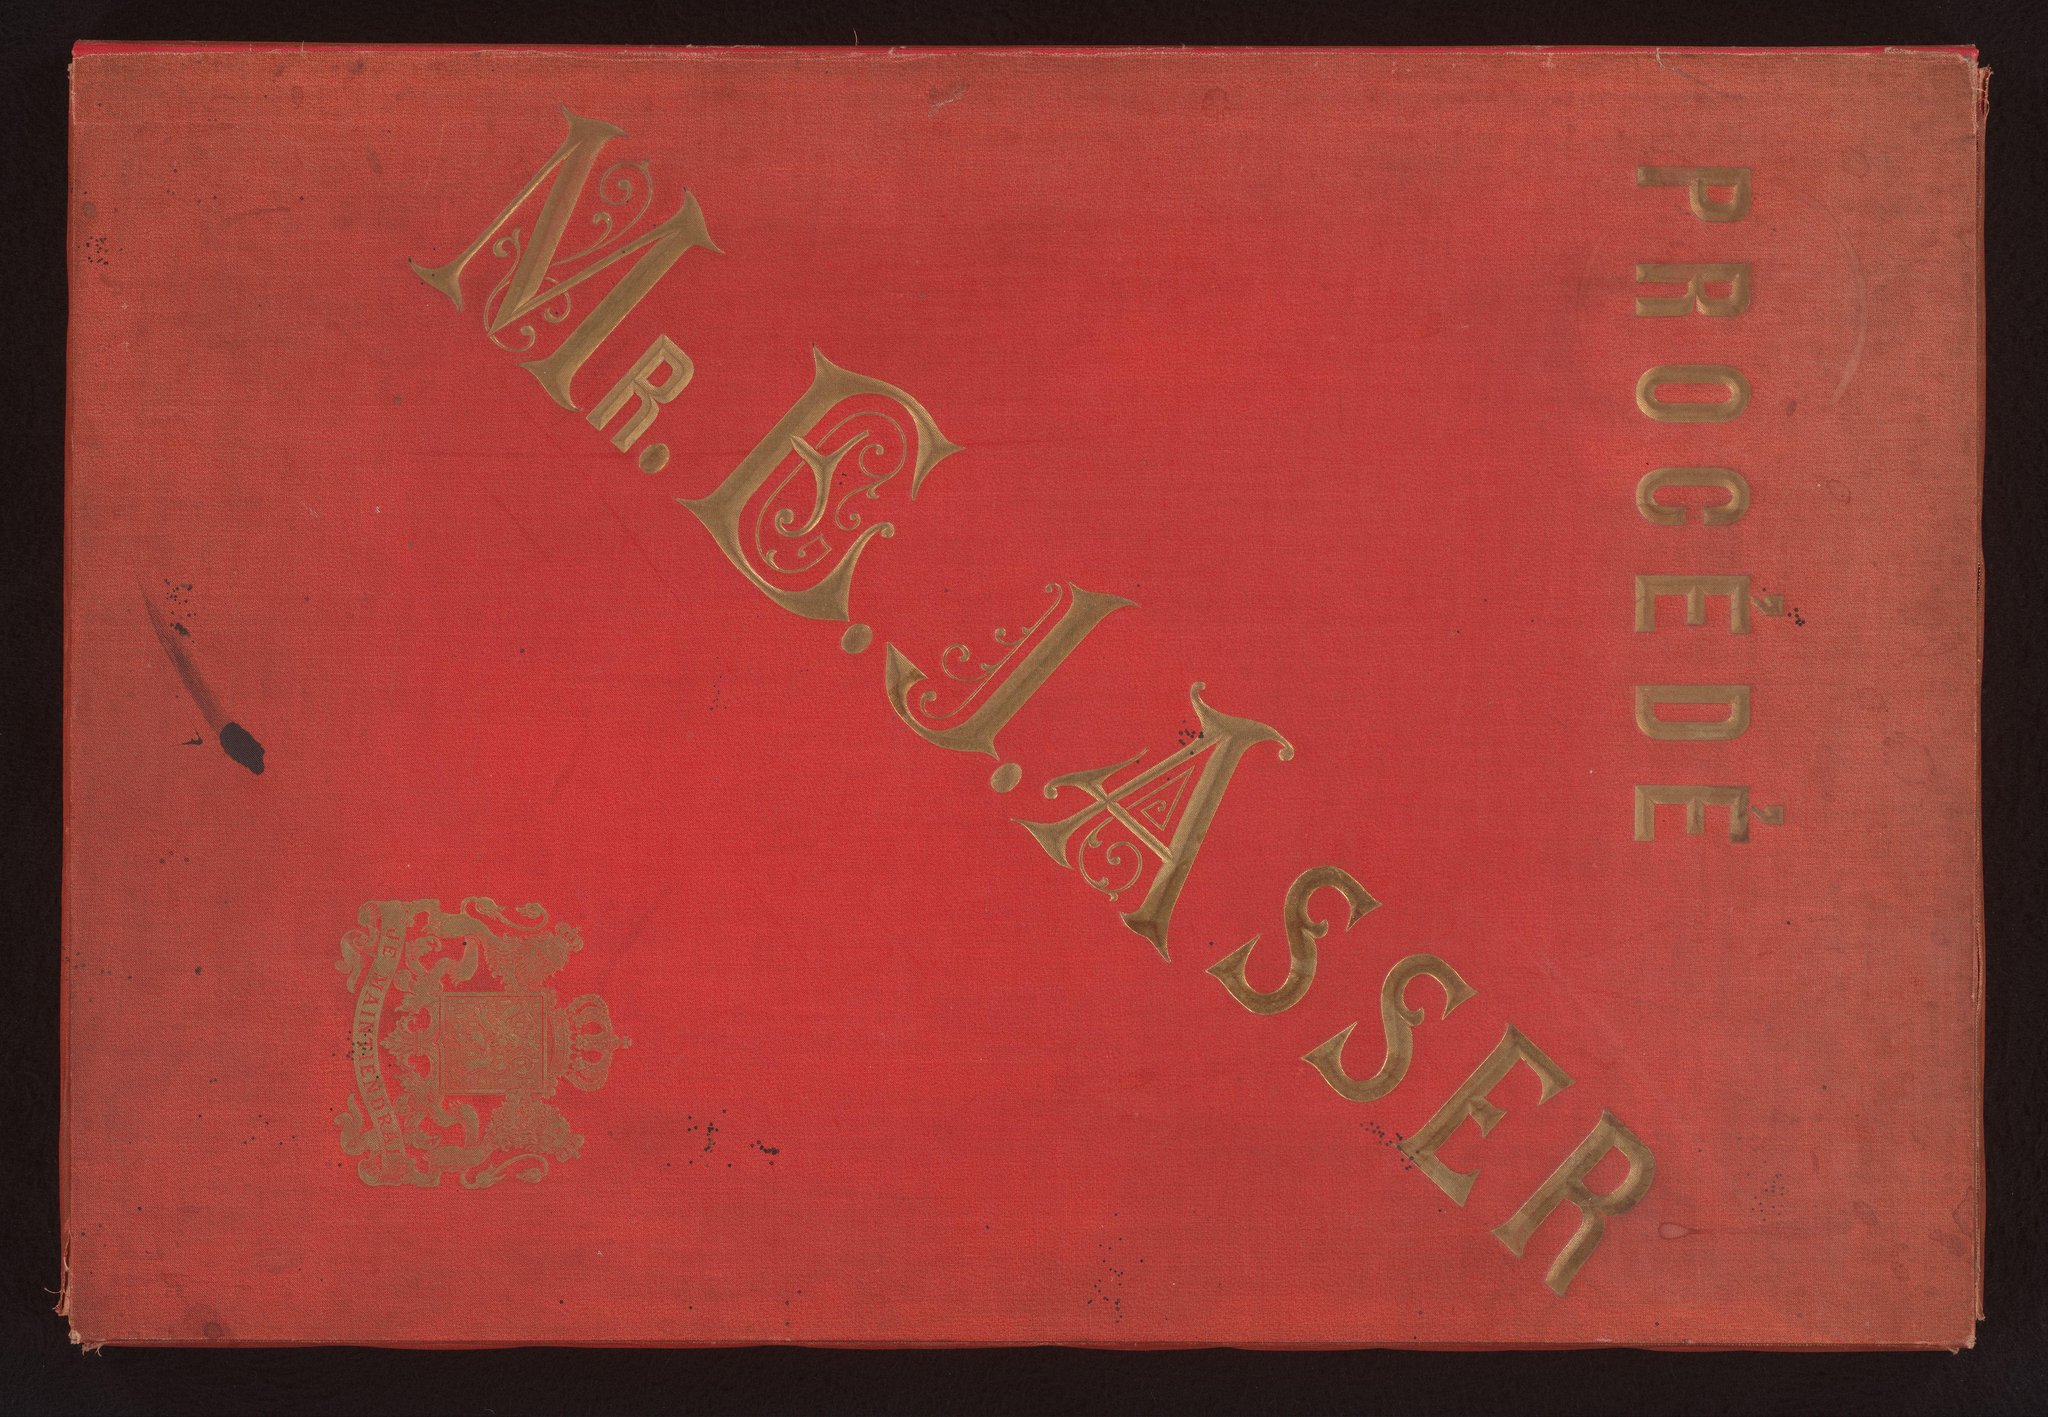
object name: photograph album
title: Procédé Mr. E.J. Asser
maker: Anonymous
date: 1892-1900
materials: cardboard, paper, textile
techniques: photograph, photolithograph, photolithography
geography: amsterdam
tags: eduard isaac asser, amsterdam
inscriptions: inscription: ‘PROCÉDÉ/ Mr. E.J.ASSER’, coat of arms: ‘JE MAINTIENDRAI’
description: Omslag met 12 fotolithografieën en lichtdrukken op losse bladen, gedrukt en uitgegeven door de Maatschappij voor Photolithographie & Zincographie.